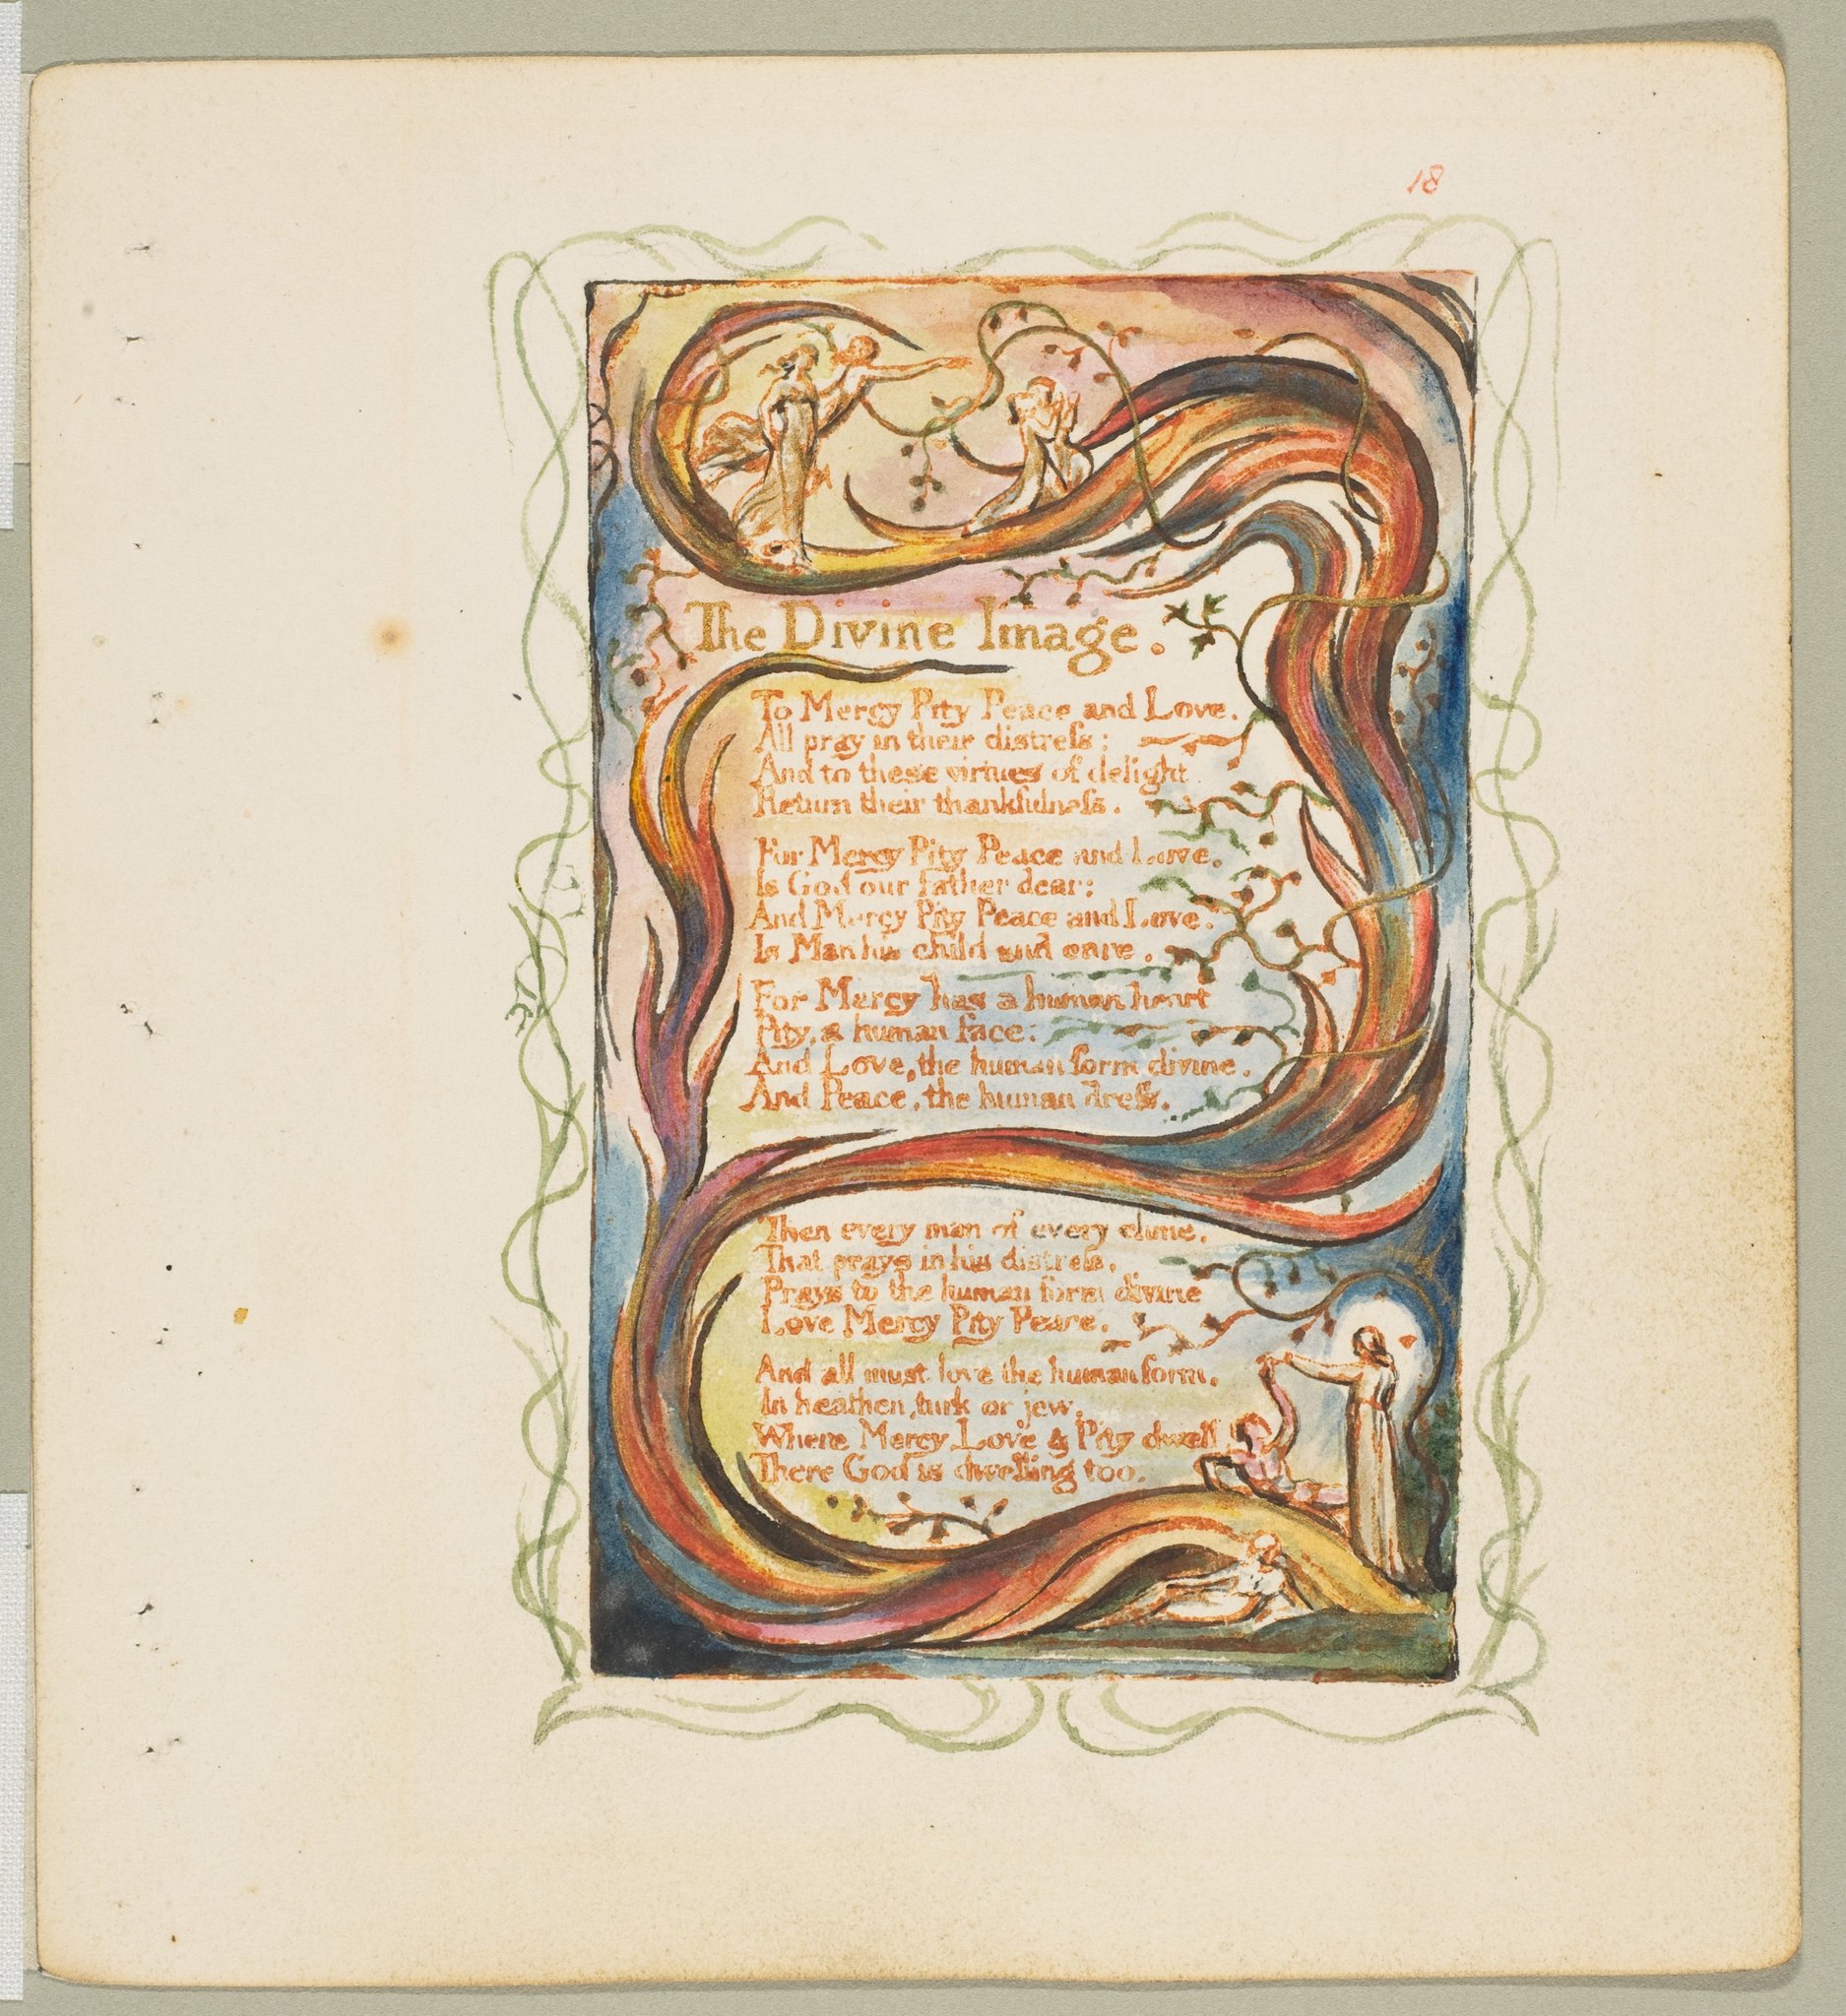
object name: print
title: Songs of Innocence: The Divine Image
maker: william blake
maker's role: artist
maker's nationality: british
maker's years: 1757-1827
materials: gold, ink, shell, watercolor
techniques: etching, hand coloring, printing, relief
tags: poetry